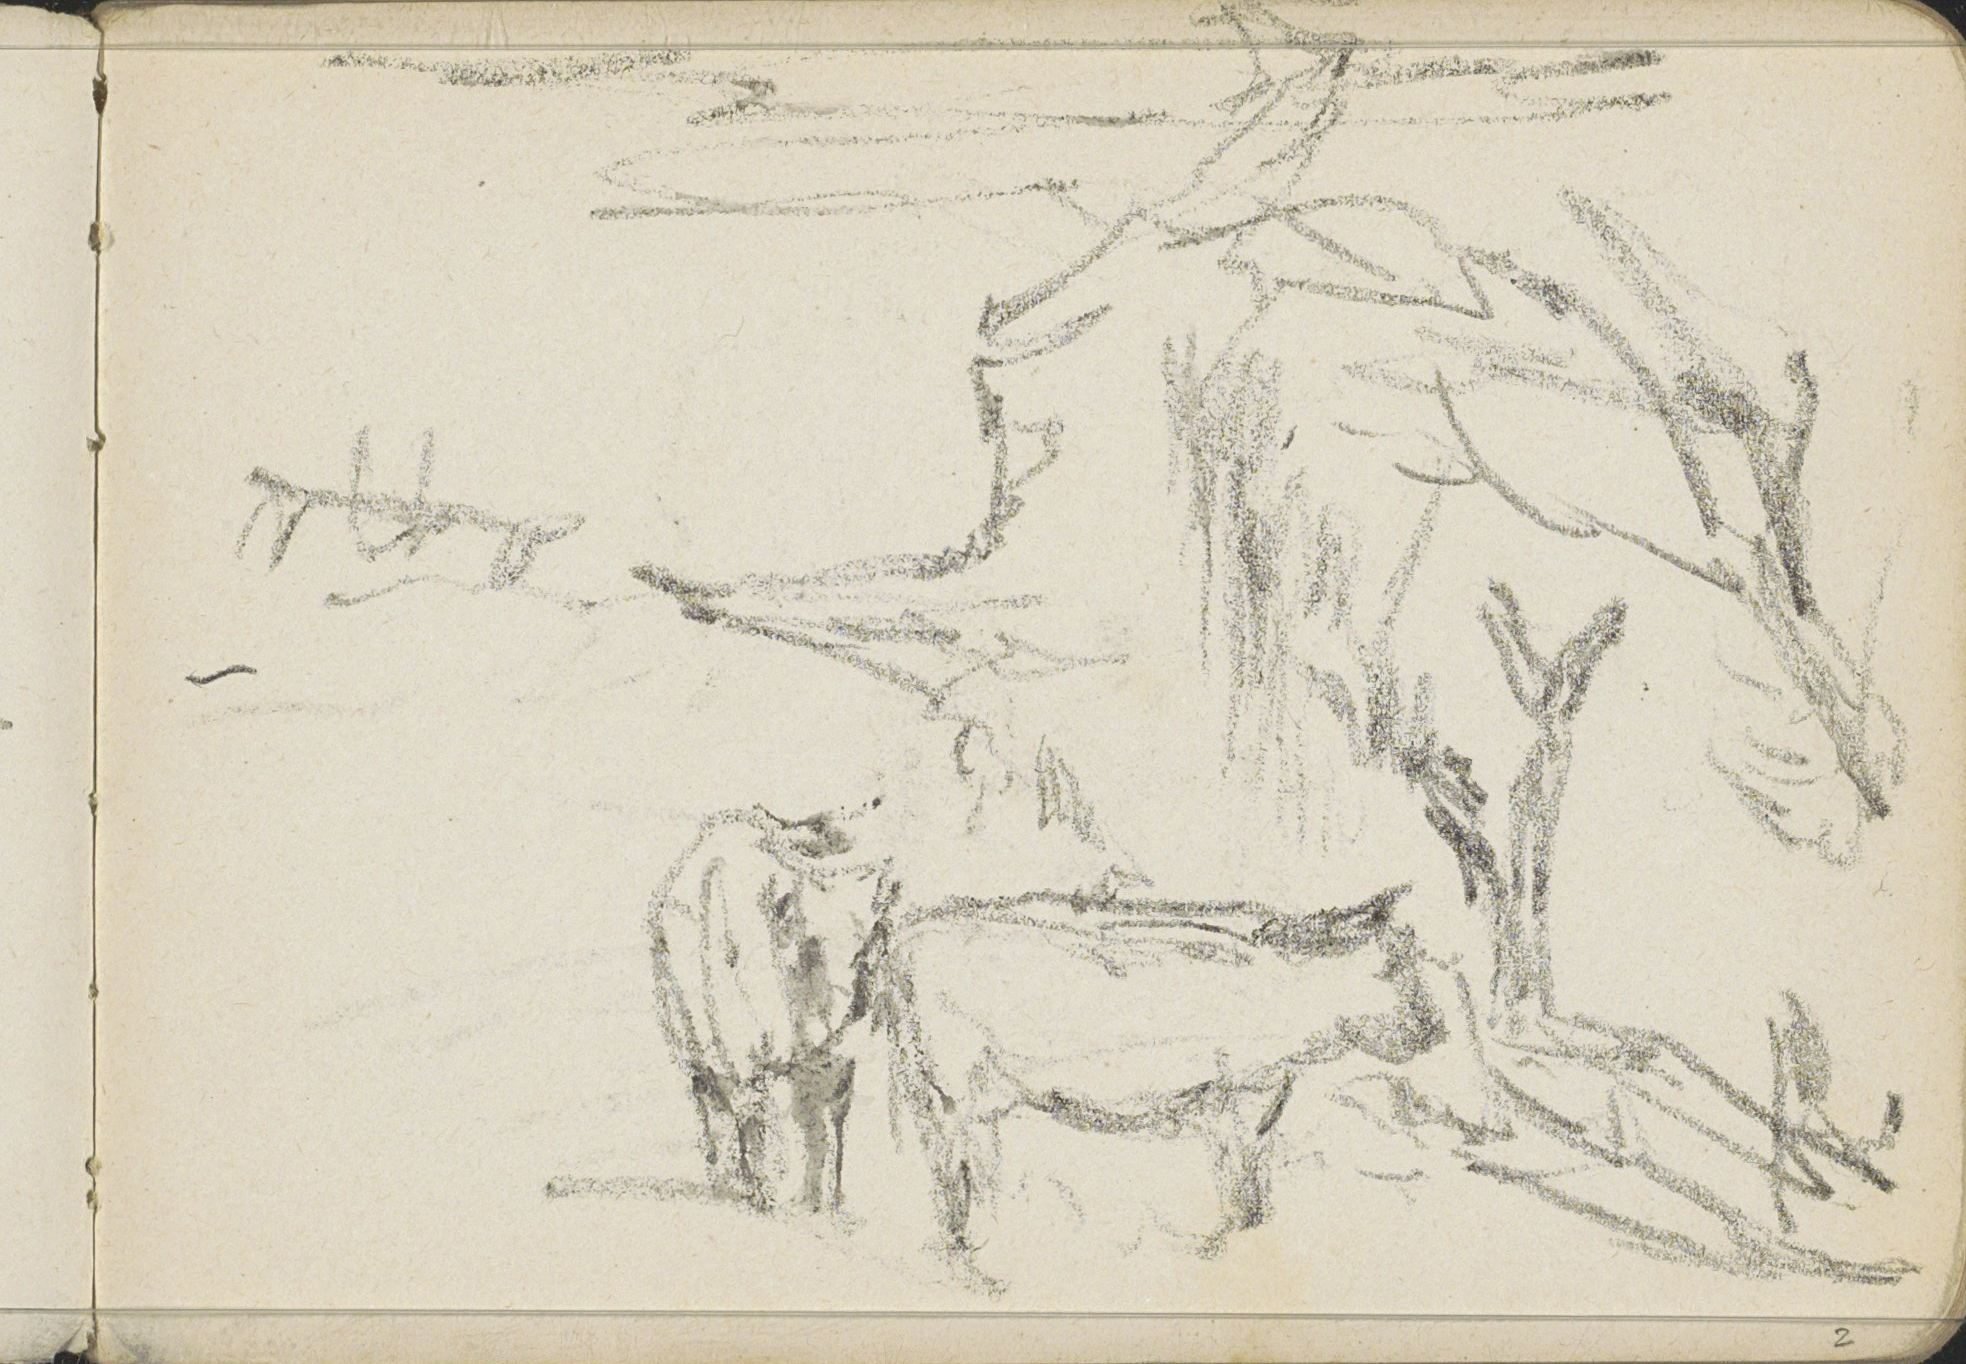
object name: sketchbook leaf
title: Twee koeien bij een hek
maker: willem cornelis rip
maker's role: draughtsman, painter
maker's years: 1856-1922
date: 1905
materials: chalk, paper, watercolor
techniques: brush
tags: cow, fence, wall, paling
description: Blad 2 recto uit een schetsboek met 42 bladen.